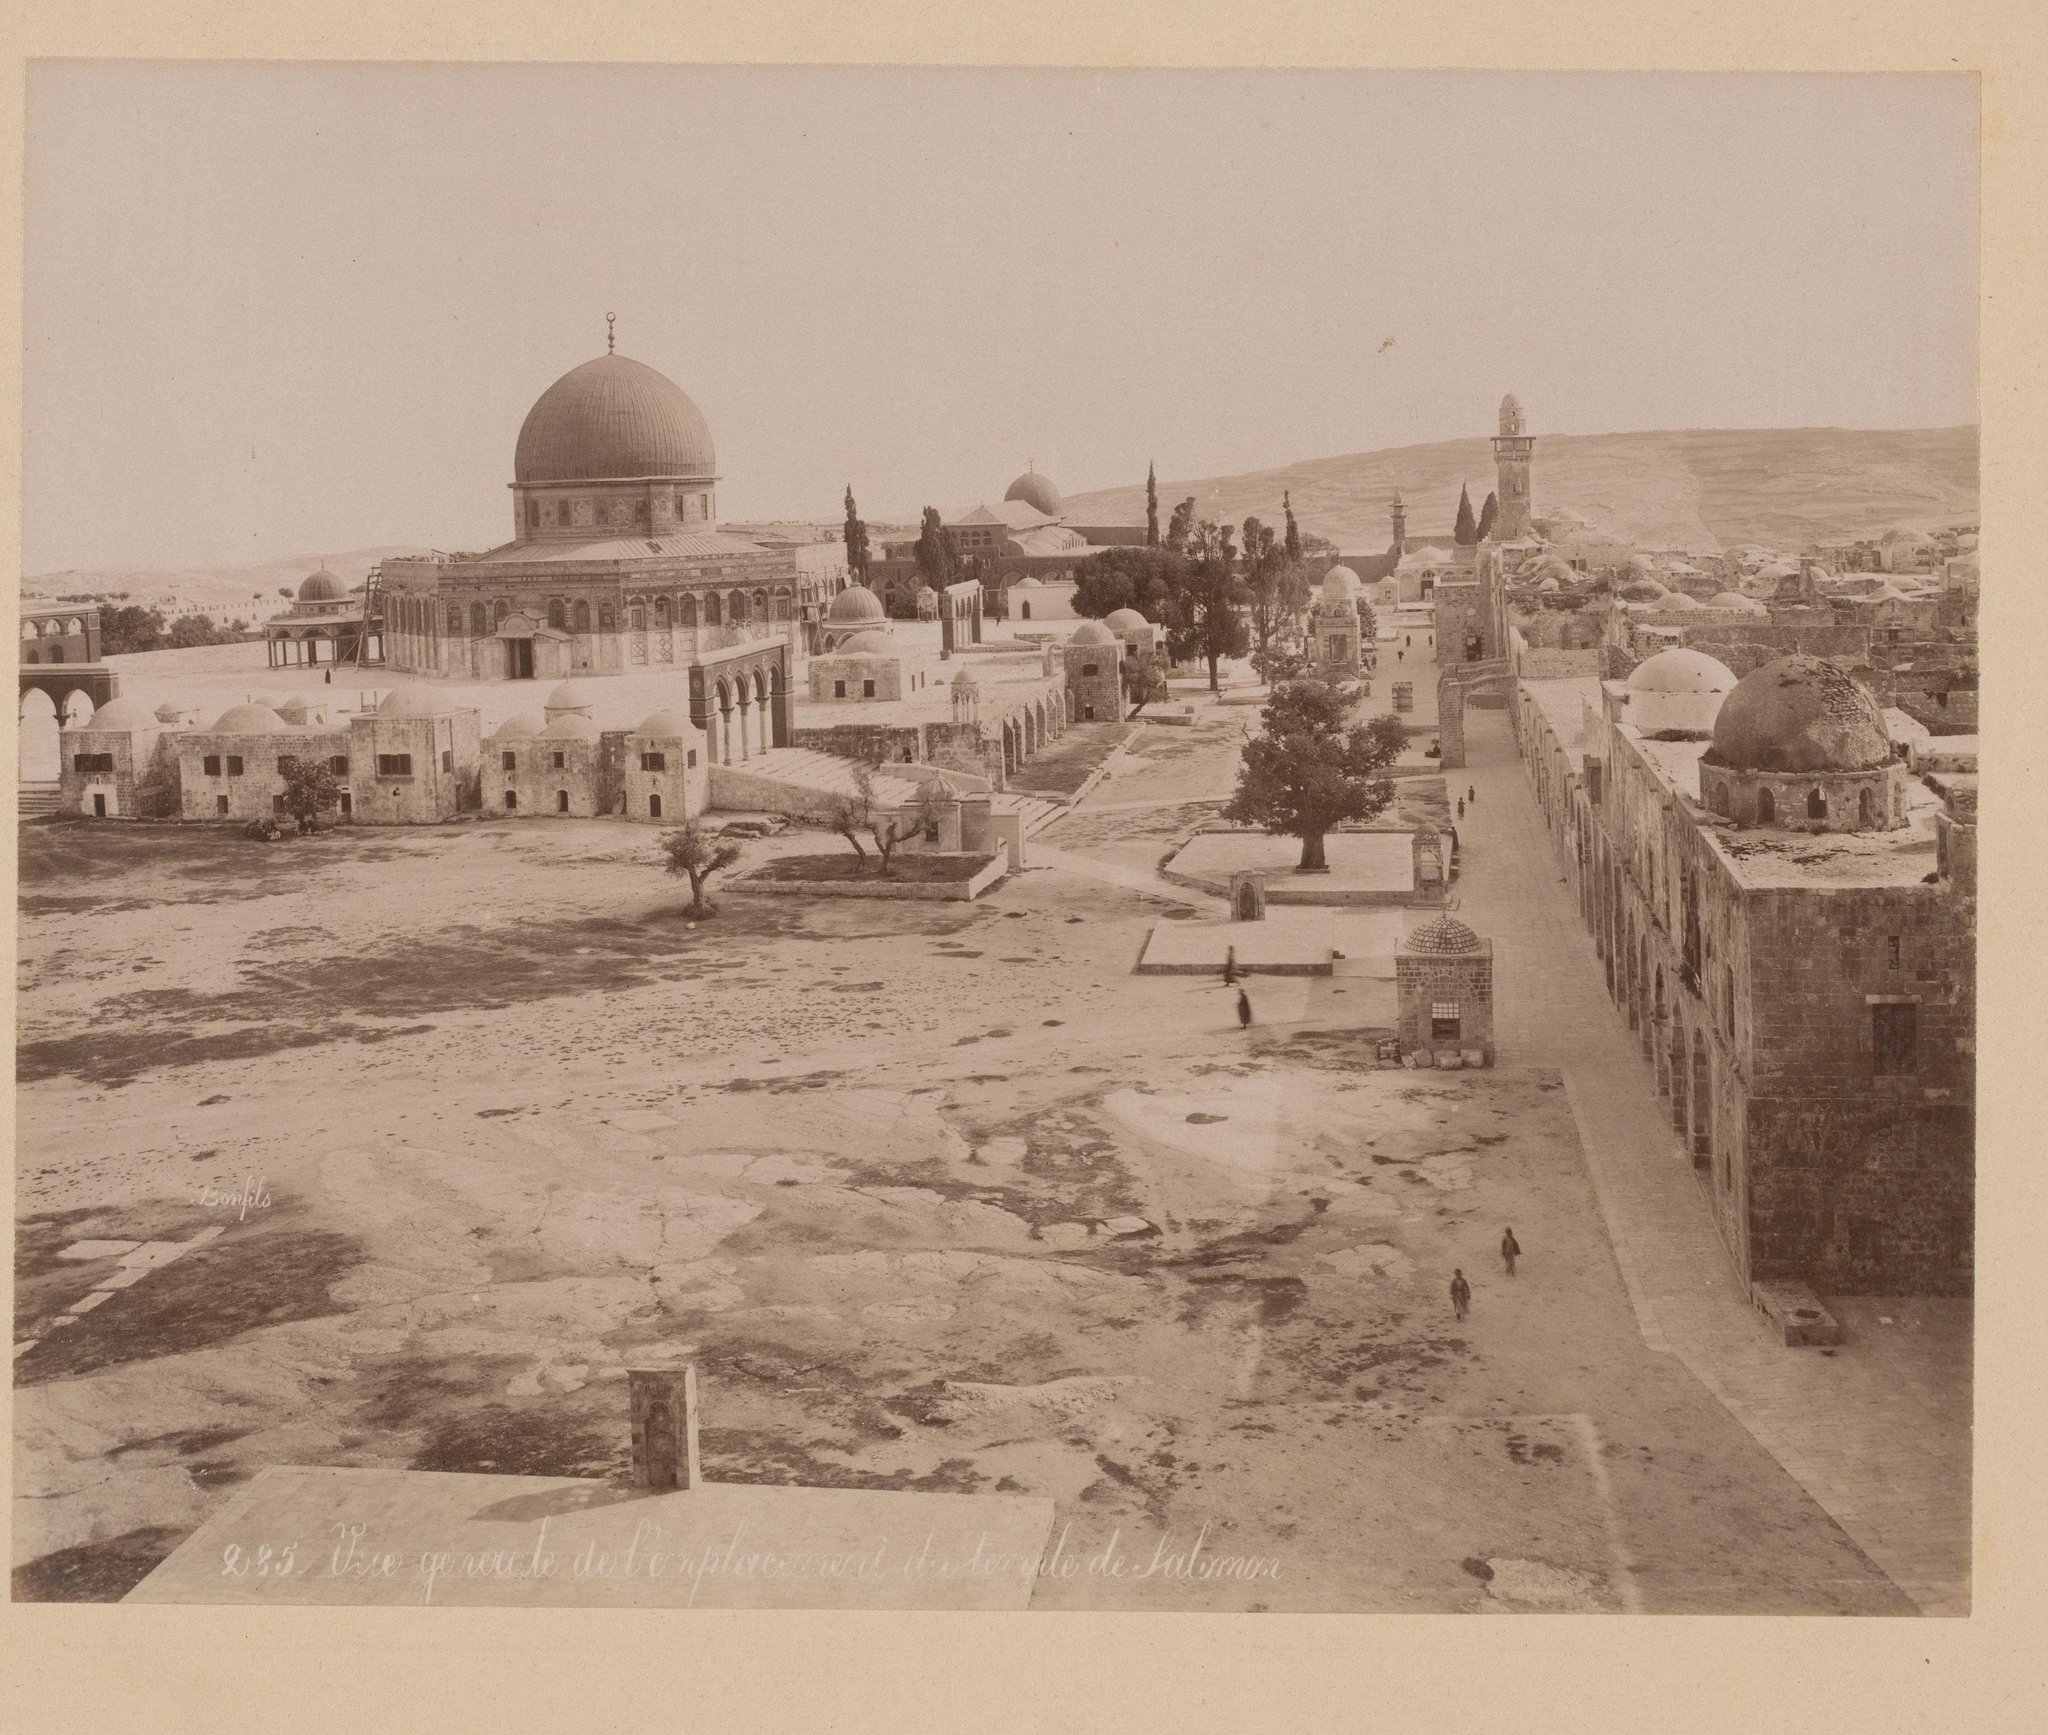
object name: photograph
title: Aanzicht op de Tempel van Salomo (Qubbat al Sakhrah en Al Aqsa Moskee), Jeruzalem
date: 1880-1890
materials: cardboard, paper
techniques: albumen print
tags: jeruzalem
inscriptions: inscription: ‘Felix Bonfils +/- 1880.’, number: ‘1048’, signature: ‘Bonfils’, inscription: ‘235. Vue generale de l'emplacement du temple de Salomon’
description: Koning Salomo bouwde in Jeruzalem de eerste Joodse Tempel, voltooid in de 10e eeuw v. Chr. en bekend als de Tempel van Salomo. Het gebouw was een opvolger van de Tabernakel, een tent die als tempel dienst deed tijdens de reis van het volk Israël van Egypte naar Kanaan, deze eerste tempel werd in 586 v. Chr. door de Babyloniërs vernietigd. De tweede tempel, die tussen 516 en 70 v. Chr. bestond, wat er over bleef was een deel van de Westelijke muur (klaagmuur; Hebreeuws: ha kotel ha-ma'aravi).